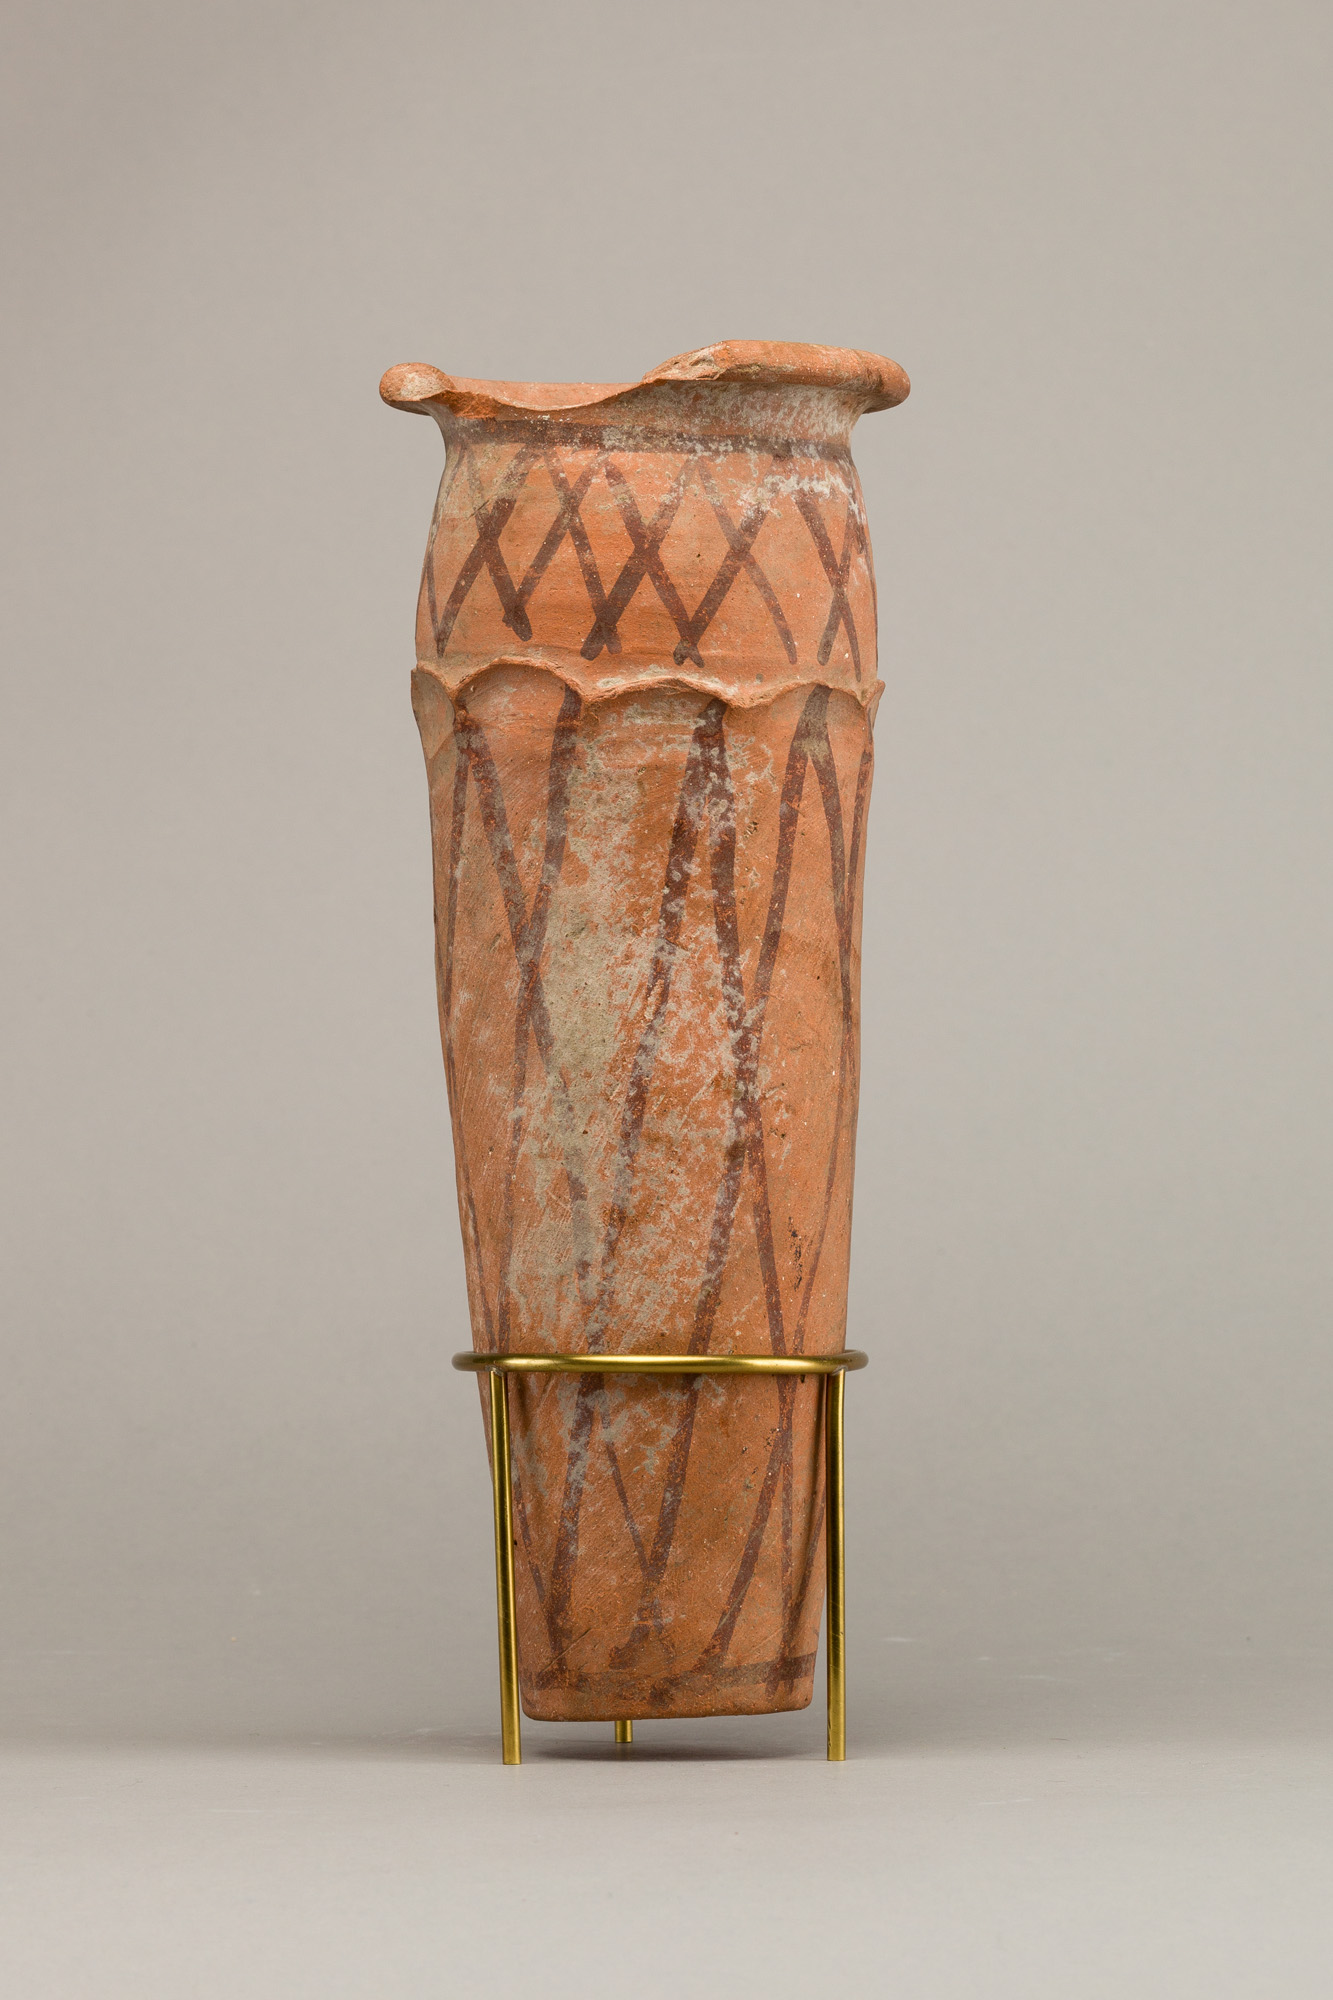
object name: jar, wavy handled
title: Wavy-handled jar with cross hatching design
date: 3850-2960 BCE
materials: paint, pottery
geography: egypt